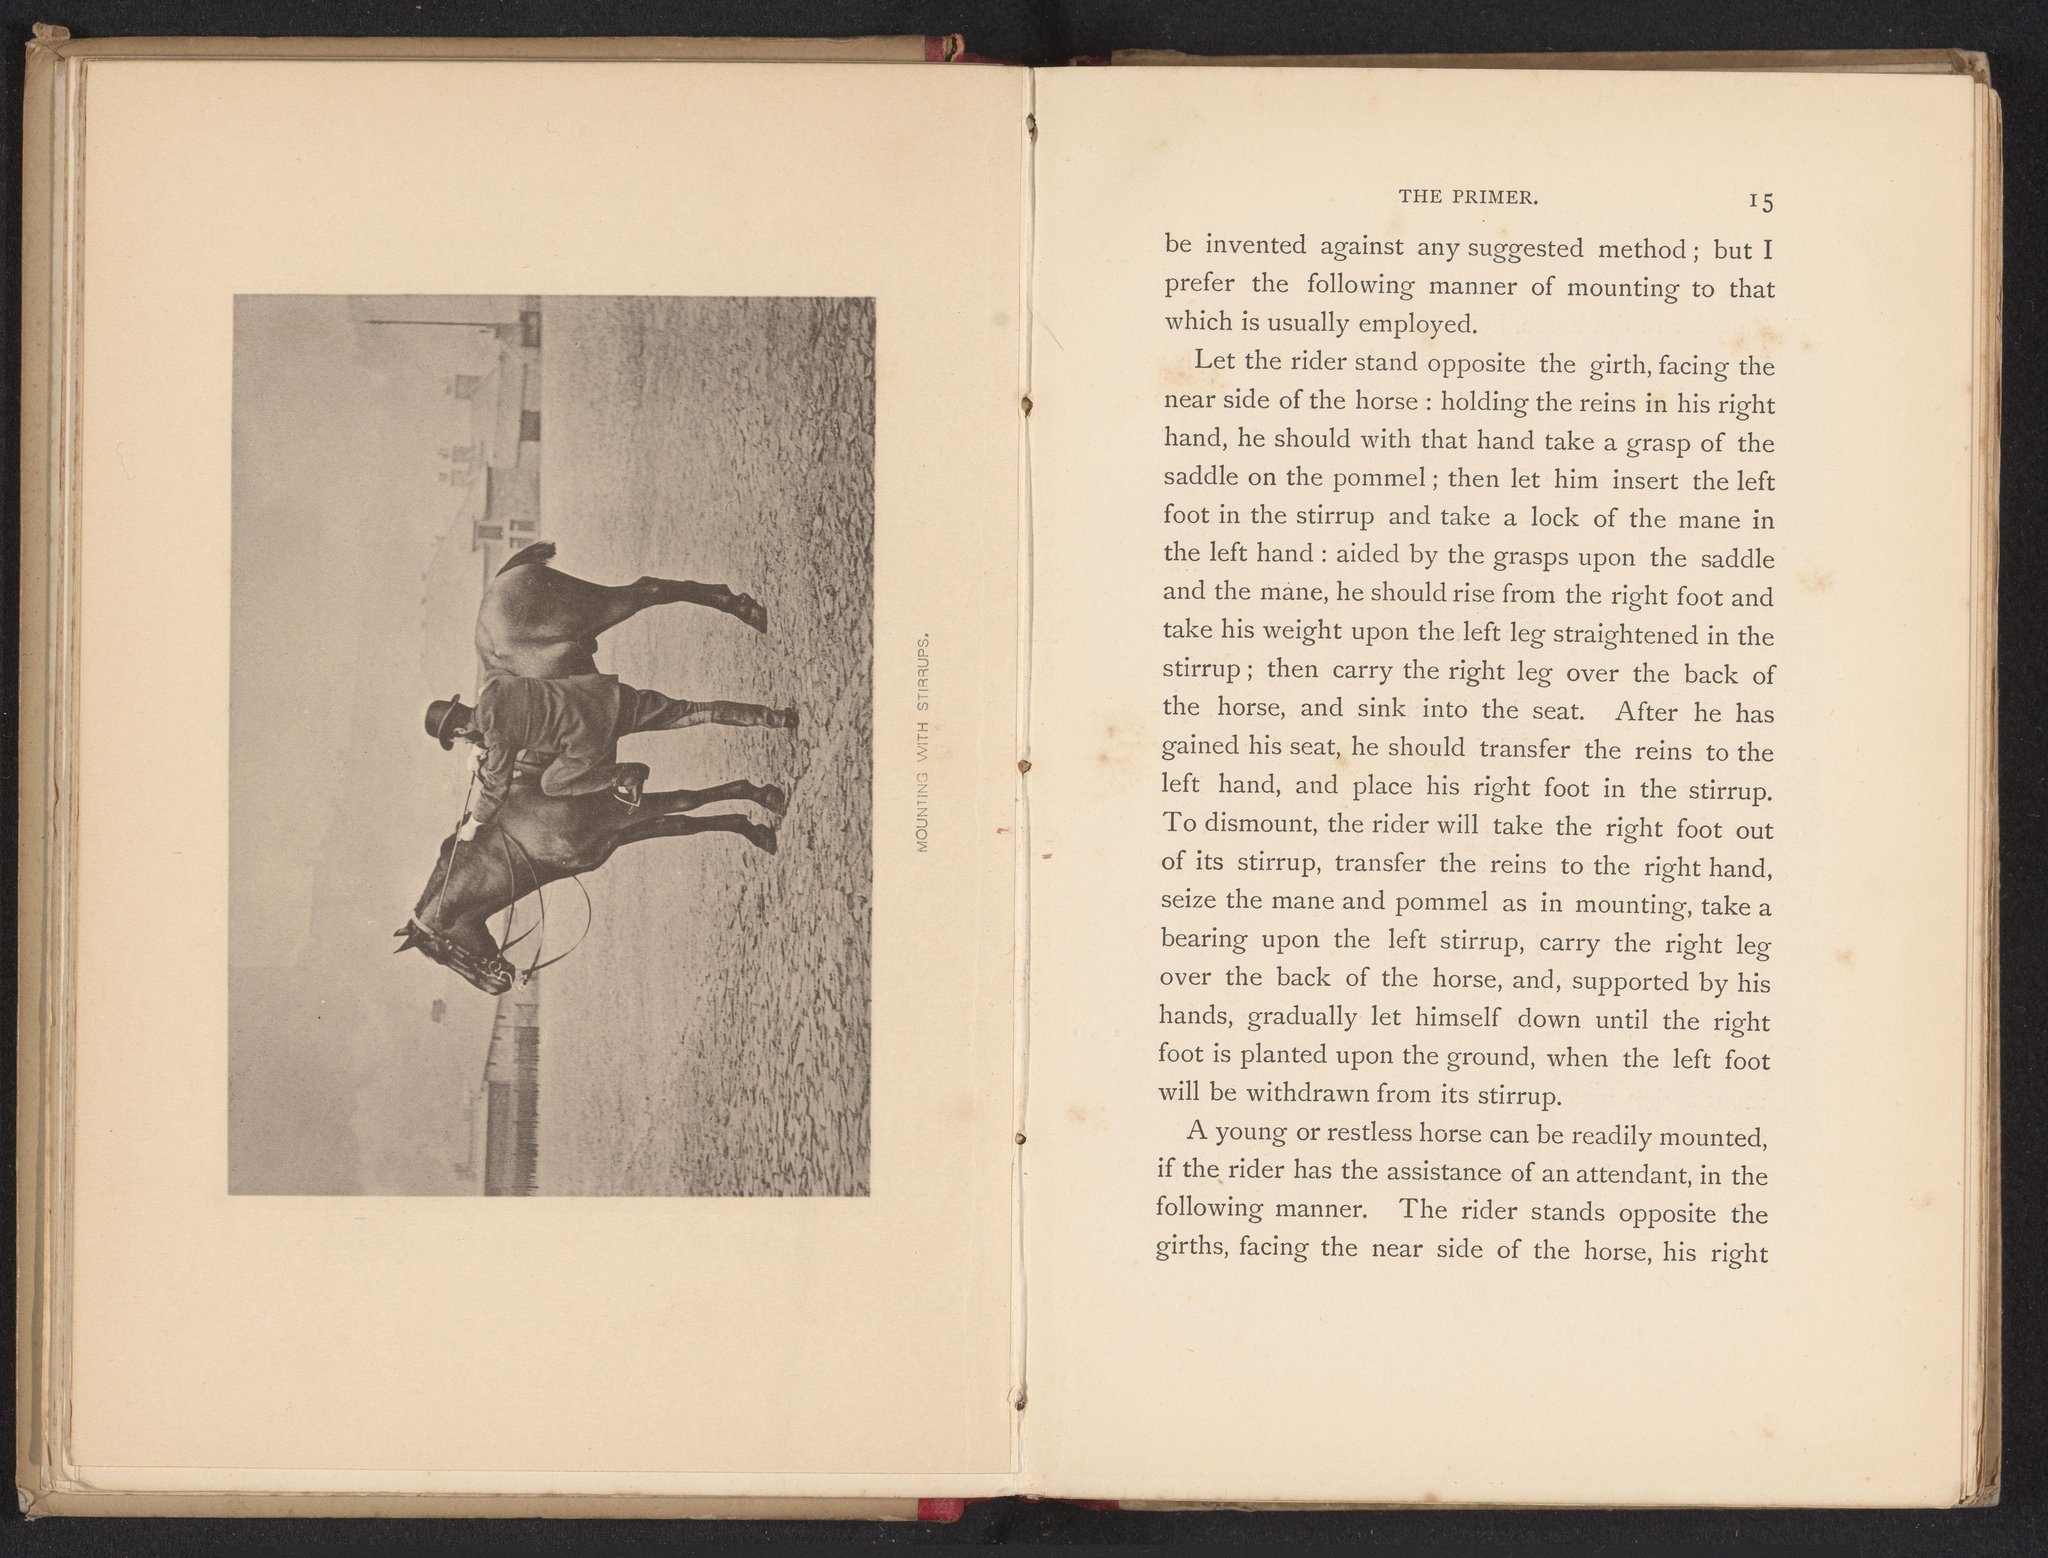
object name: photomechanical print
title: Man die een paard bestijgt met behulp van stijgbeugels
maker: Anonymous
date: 1879-1889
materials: paper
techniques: photograph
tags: riding a horse, ass, or mule; rider, horseman, head-gear: bowler hat, horse